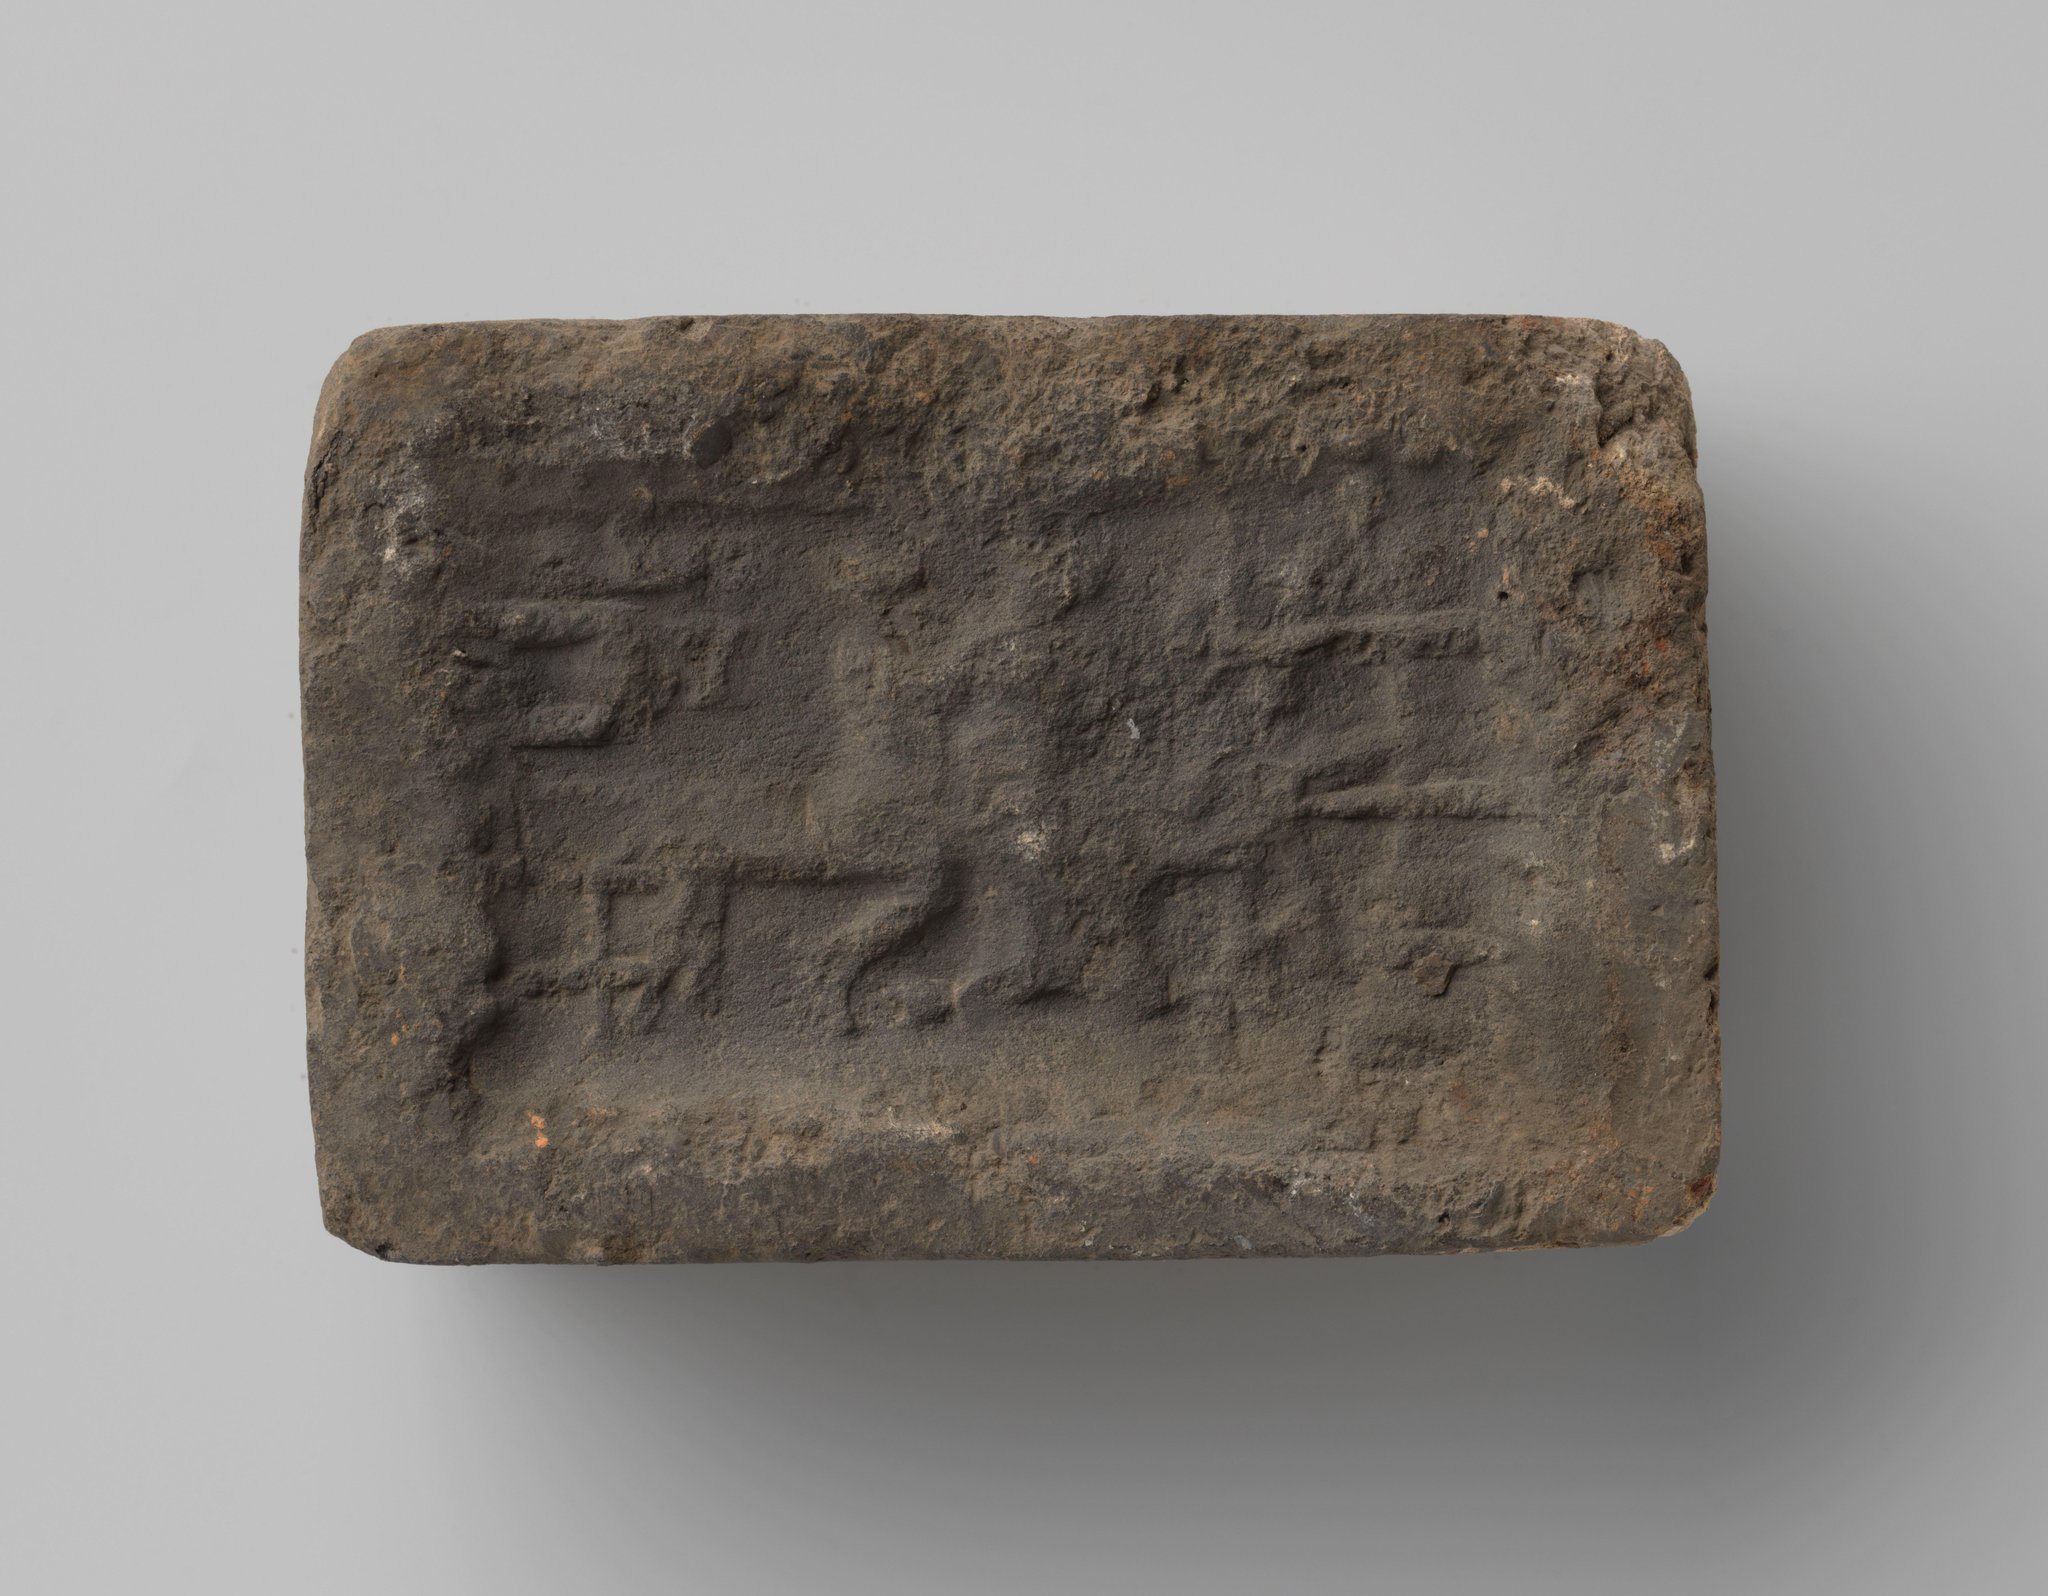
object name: hearthstone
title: Haardsteen met voorstelling van een vrijend paar, gezeten op een bank in een vertrek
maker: Anonymous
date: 1550-1575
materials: earthenware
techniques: printing, firing, vitrification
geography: southern netherlands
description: Haardsteen met voorstelling van een vrijend paar, gezeten op een bank in een vertrek. Erg afgesleten.